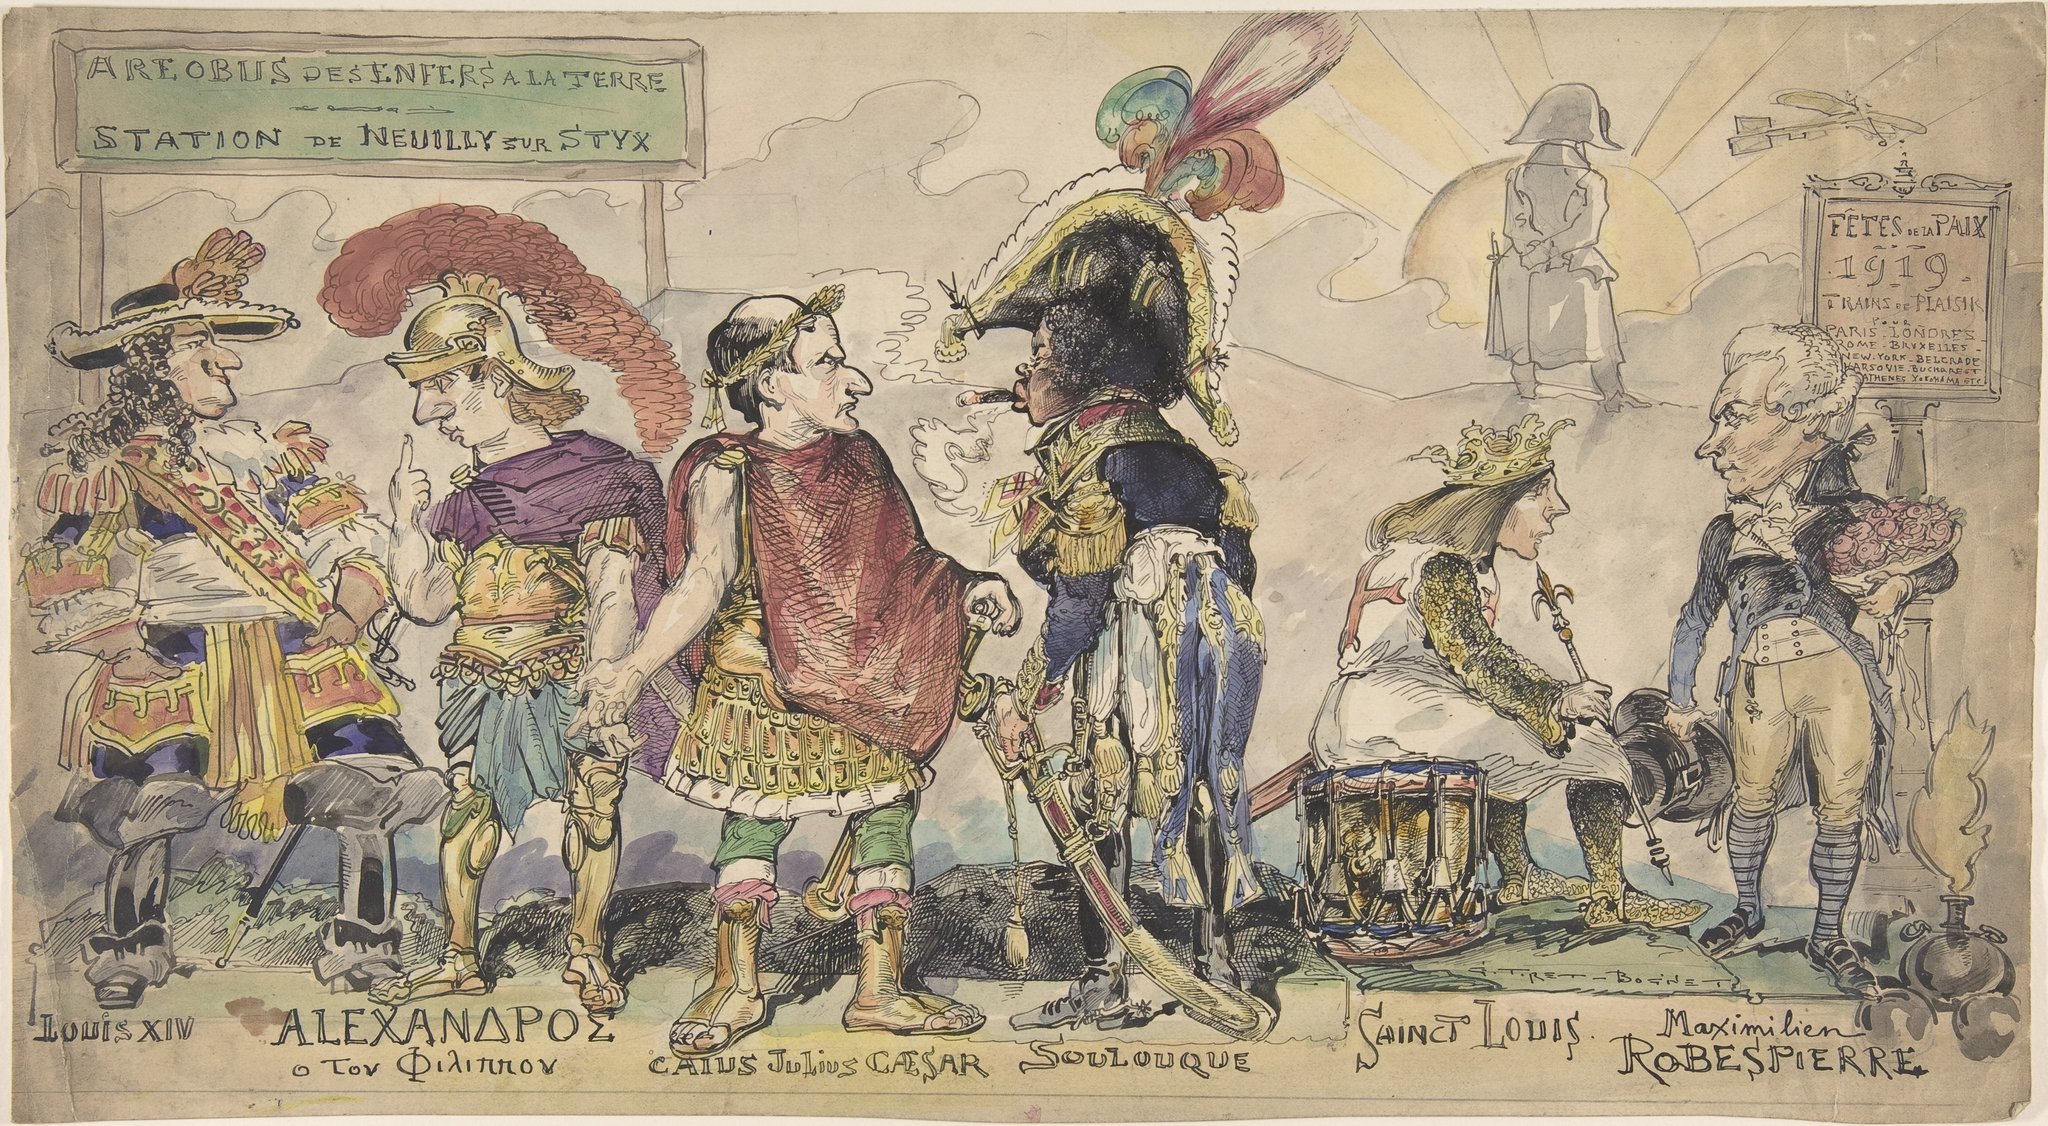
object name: drawing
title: The Bus from Hell to Earth, Peace Day, 1919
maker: georges tiret-bognet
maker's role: artist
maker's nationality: french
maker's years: 1855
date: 1919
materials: graphite, ink, watercolor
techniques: brush, pen, wash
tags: swords,men,sun